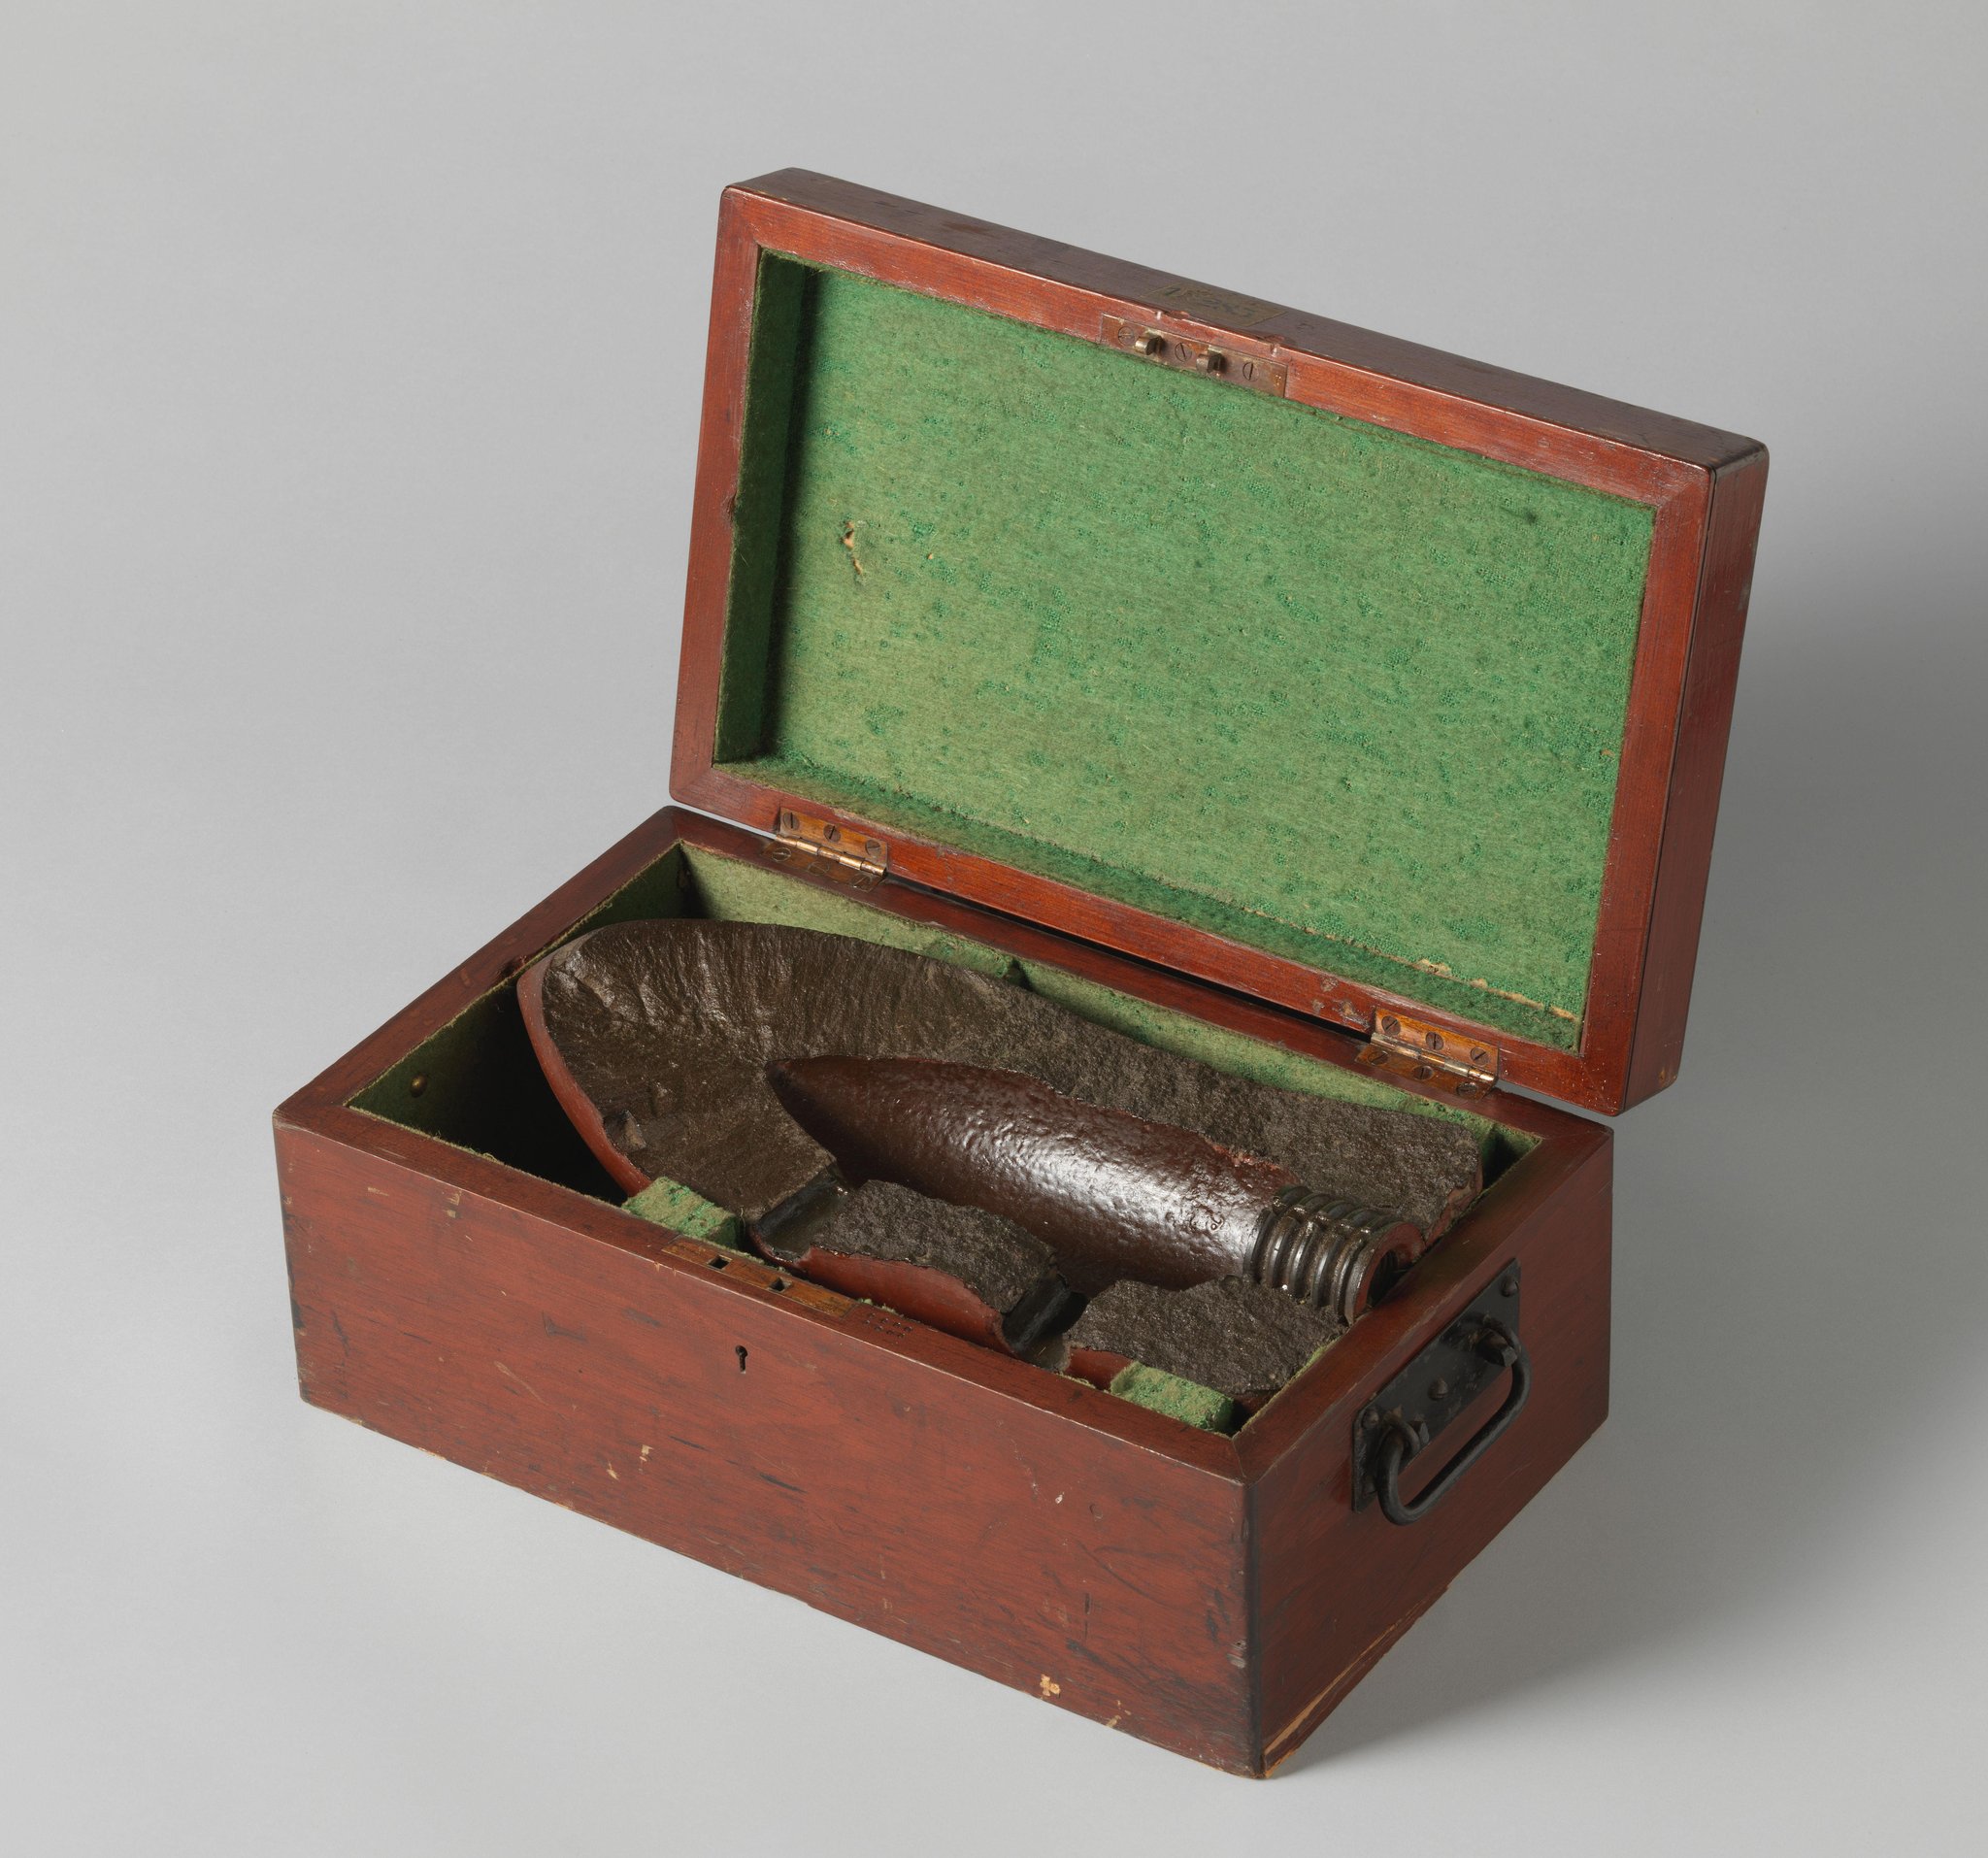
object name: chest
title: 18-cm Palliser Shell in a Wooden Box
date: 1870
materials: brass, iron, lead, wood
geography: woolwich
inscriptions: inscription, on the lock of the box: ‘[SH]ELL / [P]ALLISER John Shaw & Sons / Wolverhampton / Safety patent lever lock.’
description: Een halve puntvormige 18 cm granaat, rood geverfd, in een houten kist. De granaat is 42 cm lang en heeft een kaliber van 176 mm. Hij is in de lengte opengebarsten, de neus is nog intact. De granaat heeft twee ringen gaten voor nokken, die niet zijn aangebracht, voor een getrokken loop met drie trekkende velden en is hol; in de bodem is een bus van een zachter metaal gegoten met een vulgat. Onder de neus zijn twee ondiepe gaten aangebracht, voor de munitie-kraan. In de wand bevinden zich twee grote, taps toelopende gaten, waardoor men de granaat heeft doen barsten.